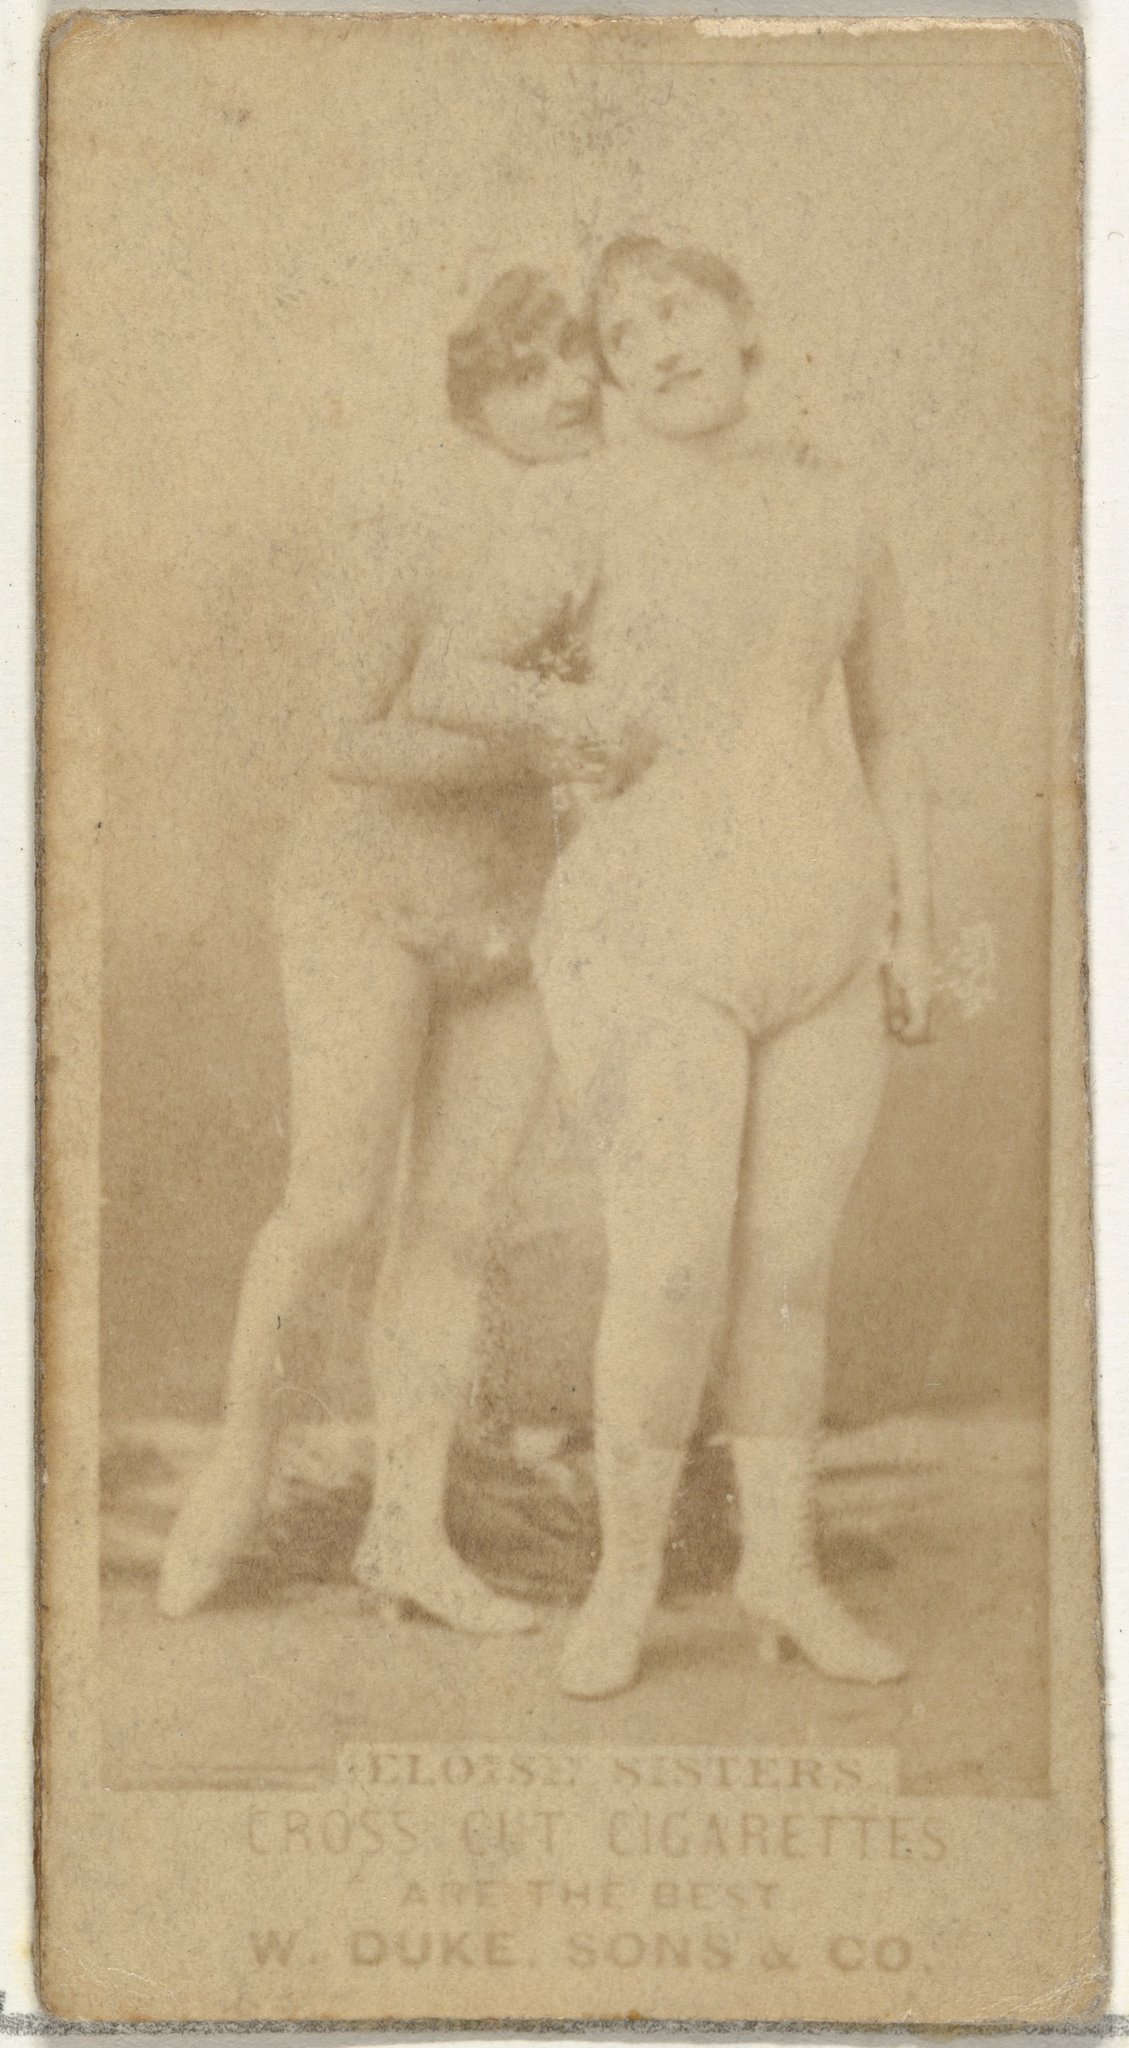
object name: photograph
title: Eloise Sisters, from the Actors and Actresses series (N145-3) issued by Duke Sons & Co. to promote Cross Cut Cigarettes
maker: w. duke, sons & co.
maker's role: publisher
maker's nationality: american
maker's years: 1870-1920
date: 1880-1889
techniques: albumen silver print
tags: portraits,women,actresses